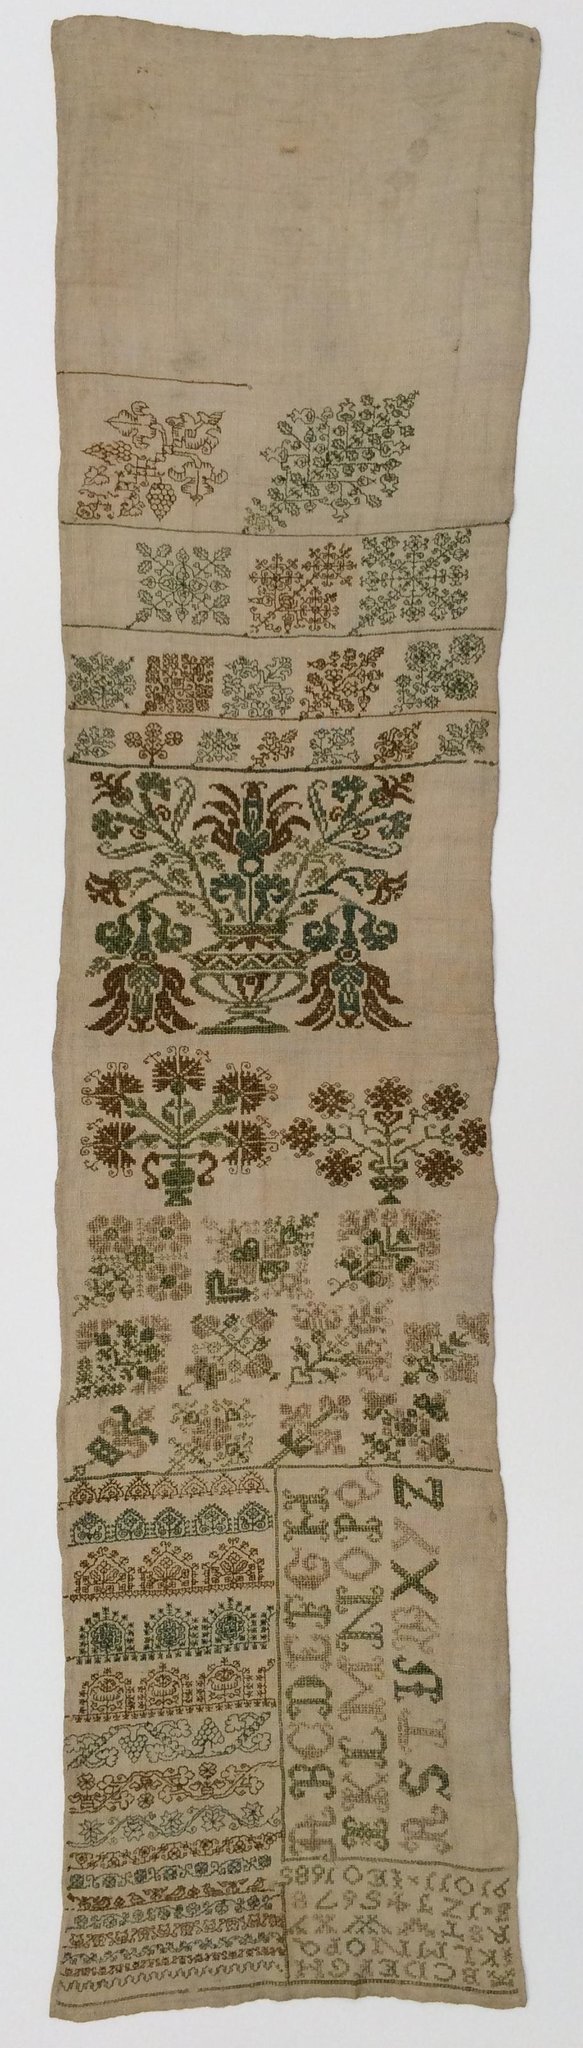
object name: sampler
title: Embroidered sampler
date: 1685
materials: linen, silk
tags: flowers